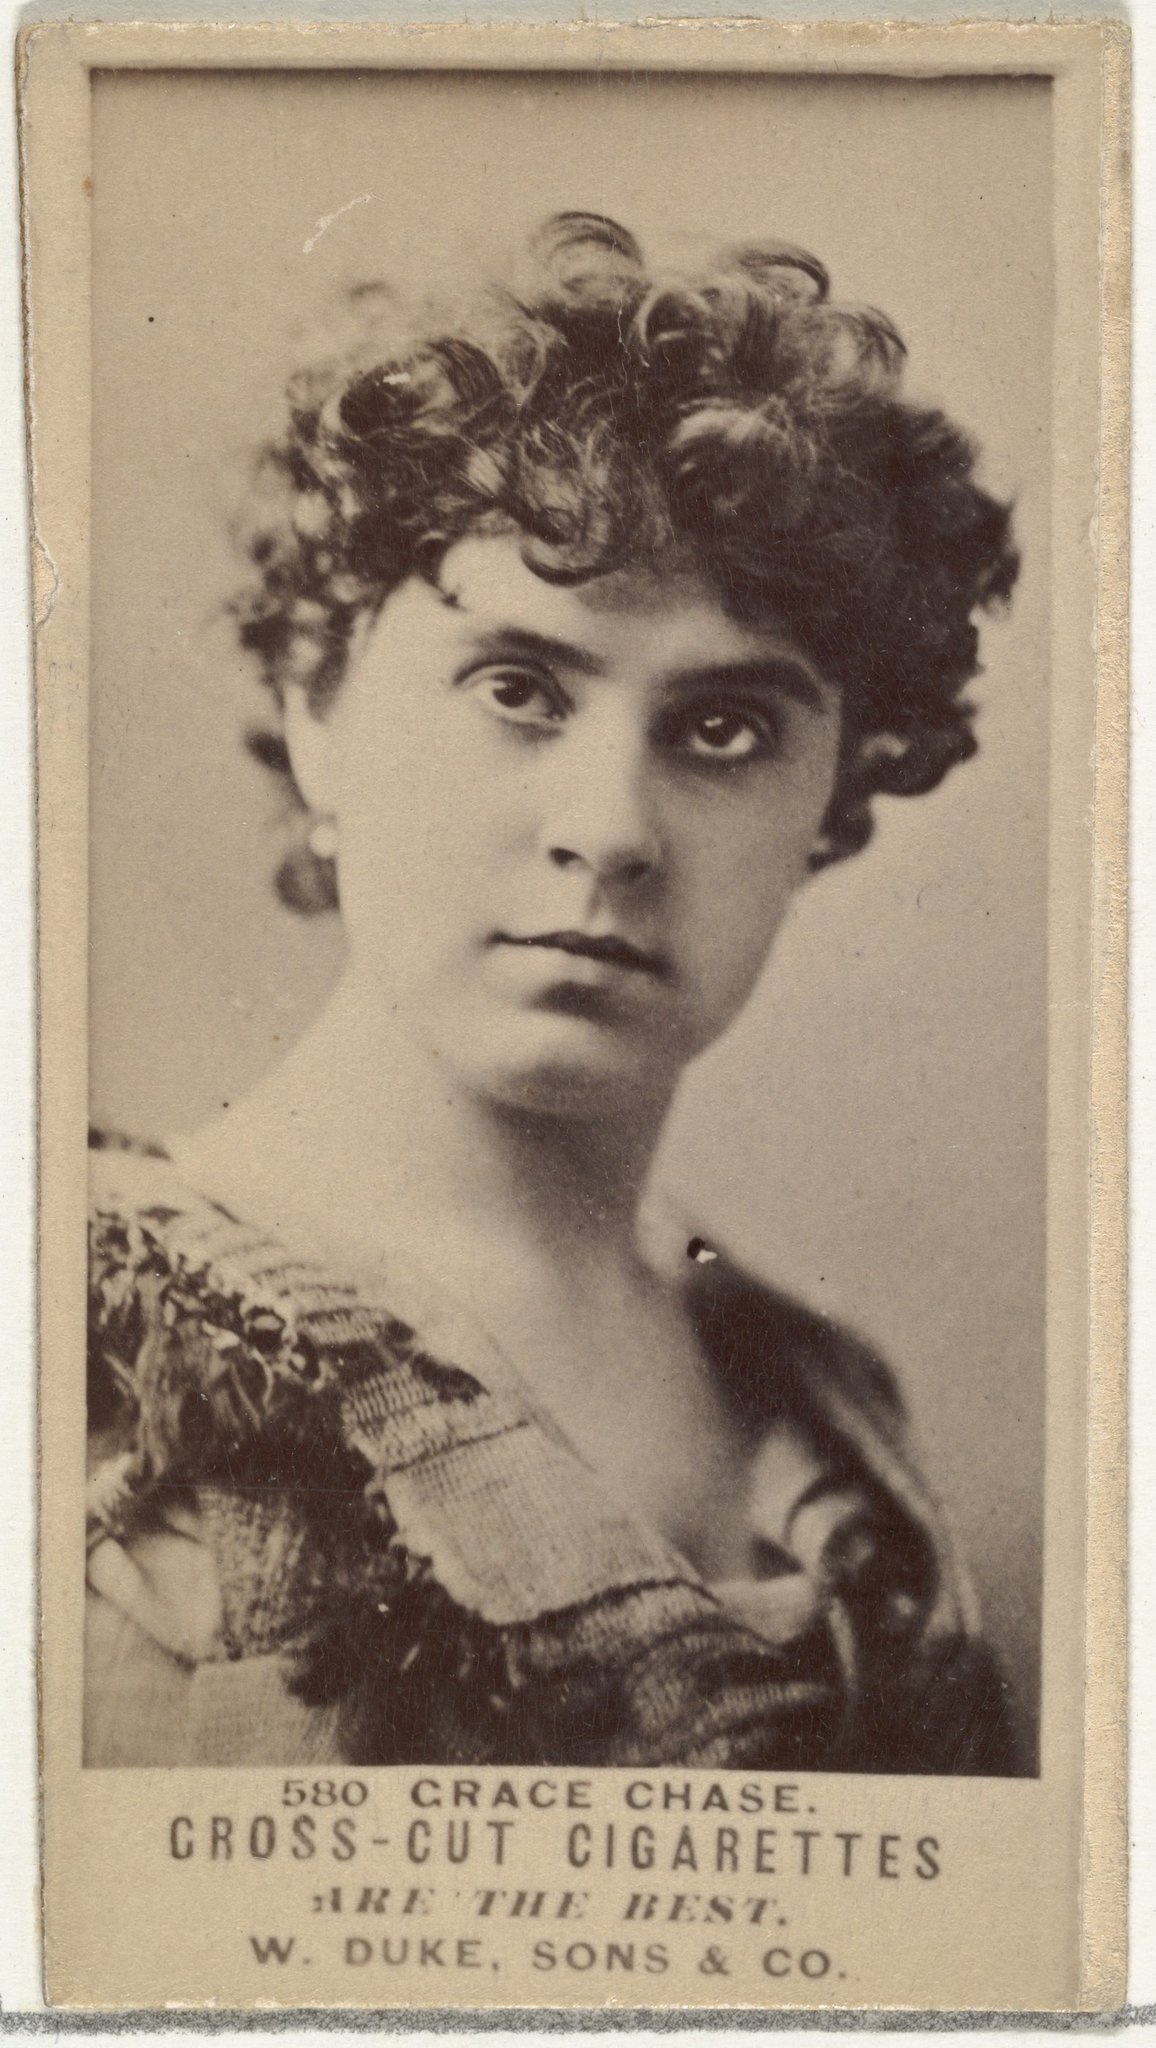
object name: photograph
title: Card Number 580, Grace Chase, from the Actors and Actresses series (N145-3) issued by Duke Sons & Co. to promote Cross Cut Cigarettes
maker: w. duke, sons & co.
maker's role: publisher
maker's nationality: american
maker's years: 1870-1920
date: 1880-1889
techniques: albumen silver print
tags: portraits,women,actresses